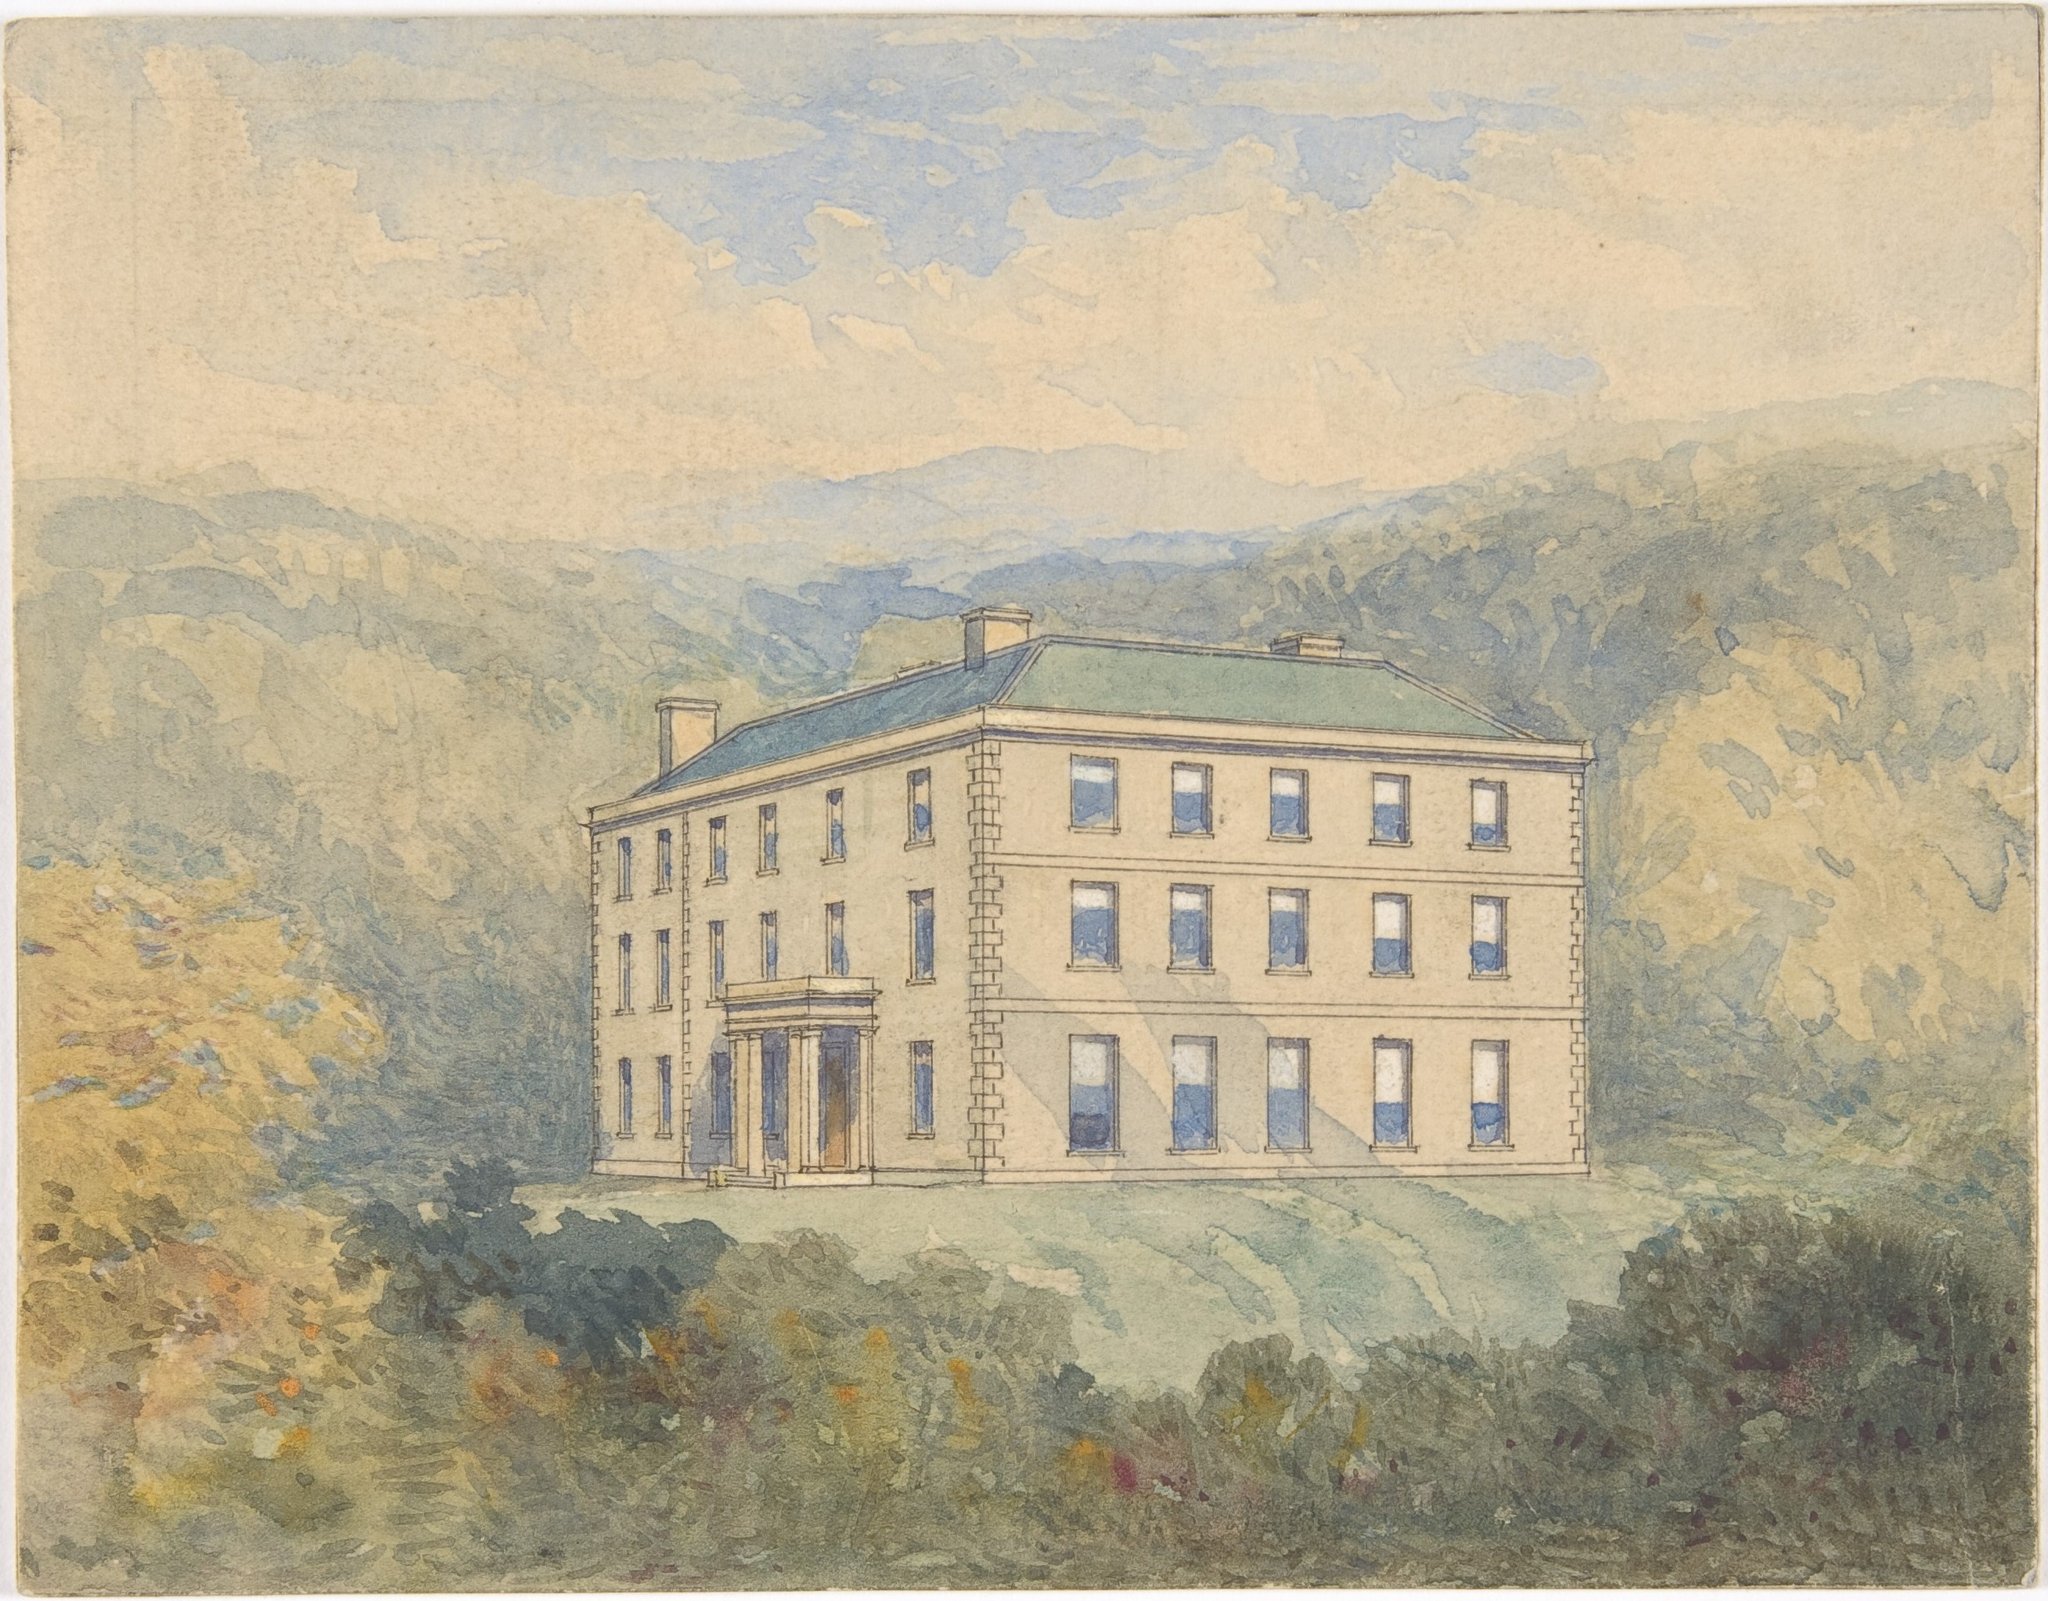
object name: drawing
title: Country house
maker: anonymous, british, 19th century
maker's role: artist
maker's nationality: british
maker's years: 1800-1900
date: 1801-1900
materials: watercolor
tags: houses,mountains,trees